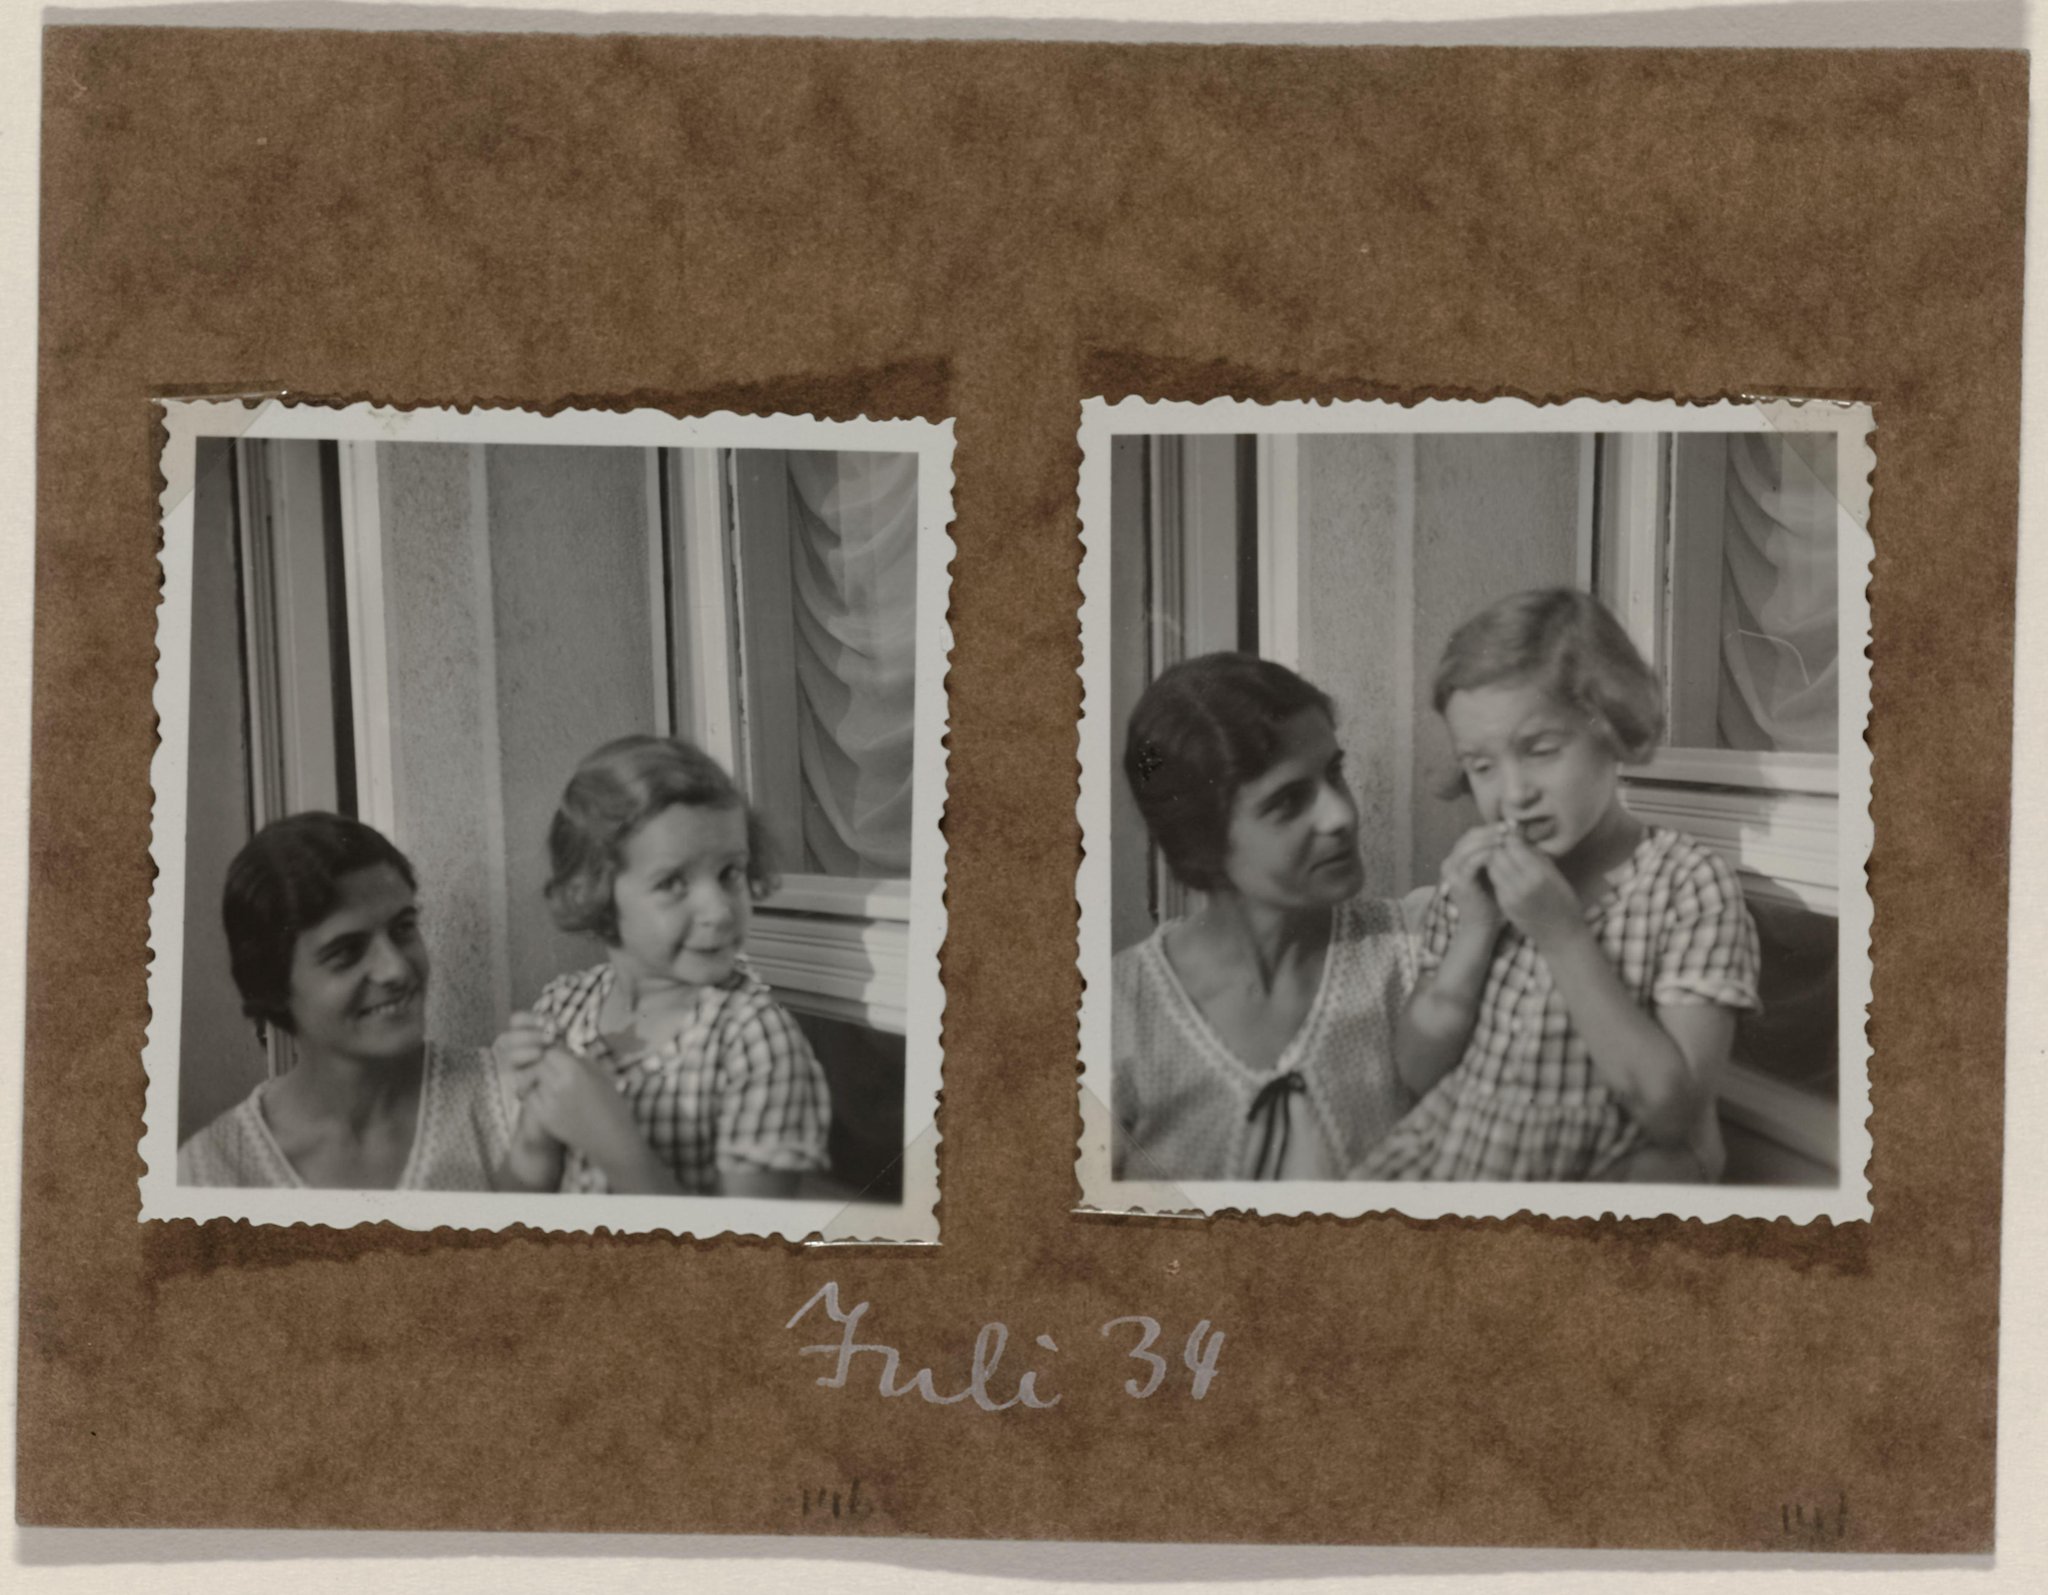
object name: photograph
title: Isabel Wachenheimer en een lid van de huishoudelijke staf, juli 1934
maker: Anonymous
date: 1907-1934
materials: photographic support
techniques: gelatin silver print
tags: leiden, isabel wachenheimer-elon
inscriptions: date: ‘Juli 34’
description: Isabel Wachenheimer en een onbekend lid van de huishoudelijke staf.